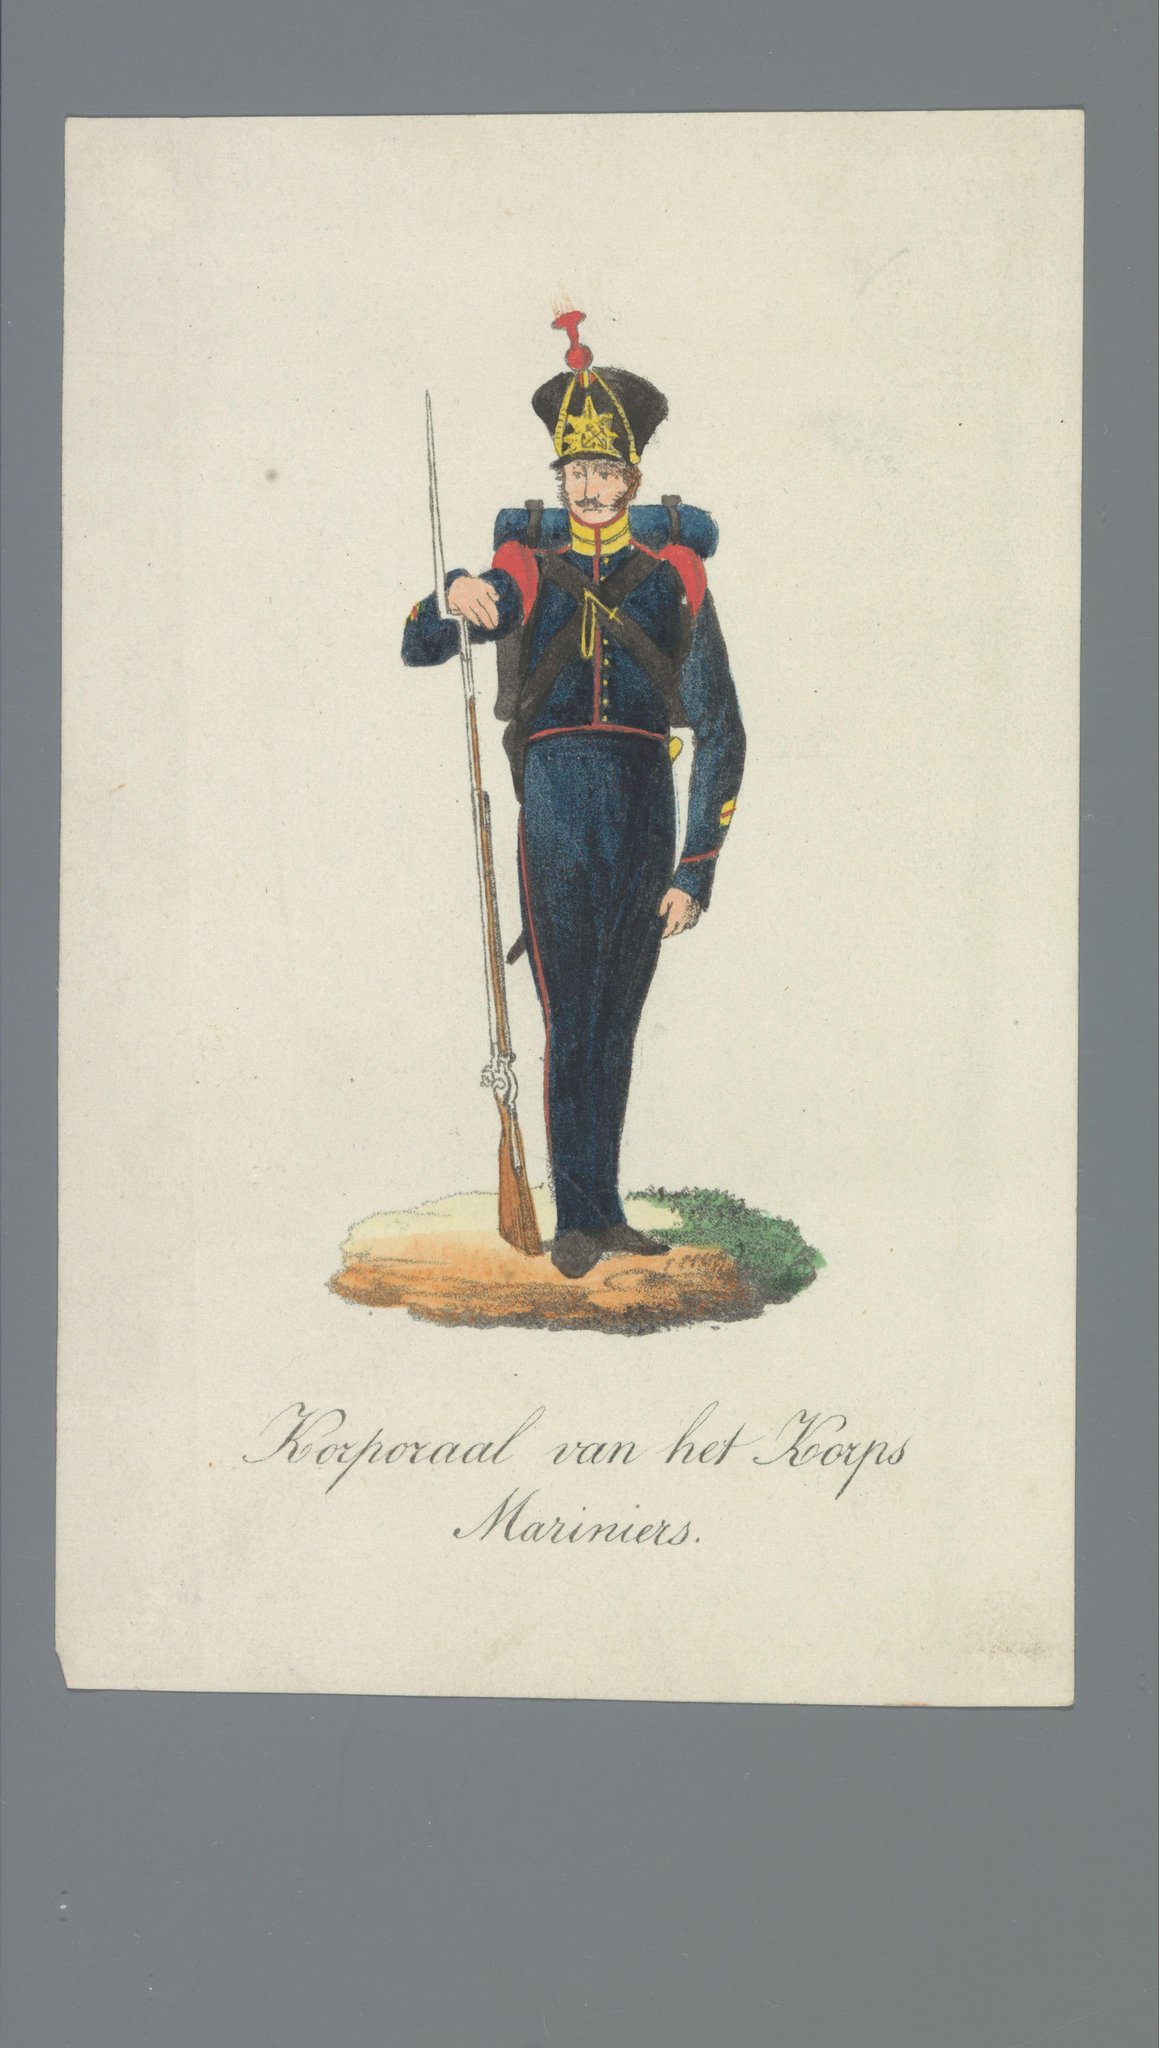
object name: print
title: Nederlandse militaire uniformen in de jaren 1830-1832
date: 1835-1850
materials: paper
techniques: hand coloring, lithograph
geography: utrecht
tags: (military) uniforms, clothes, costume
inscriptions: collector's mark: Lugt 2228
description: Een korporaal van het Korps Mariniers. Onderdeel van een serie van 157 losse bladen met Nederlandse militaire uniformen in de jaren 1830-1832.